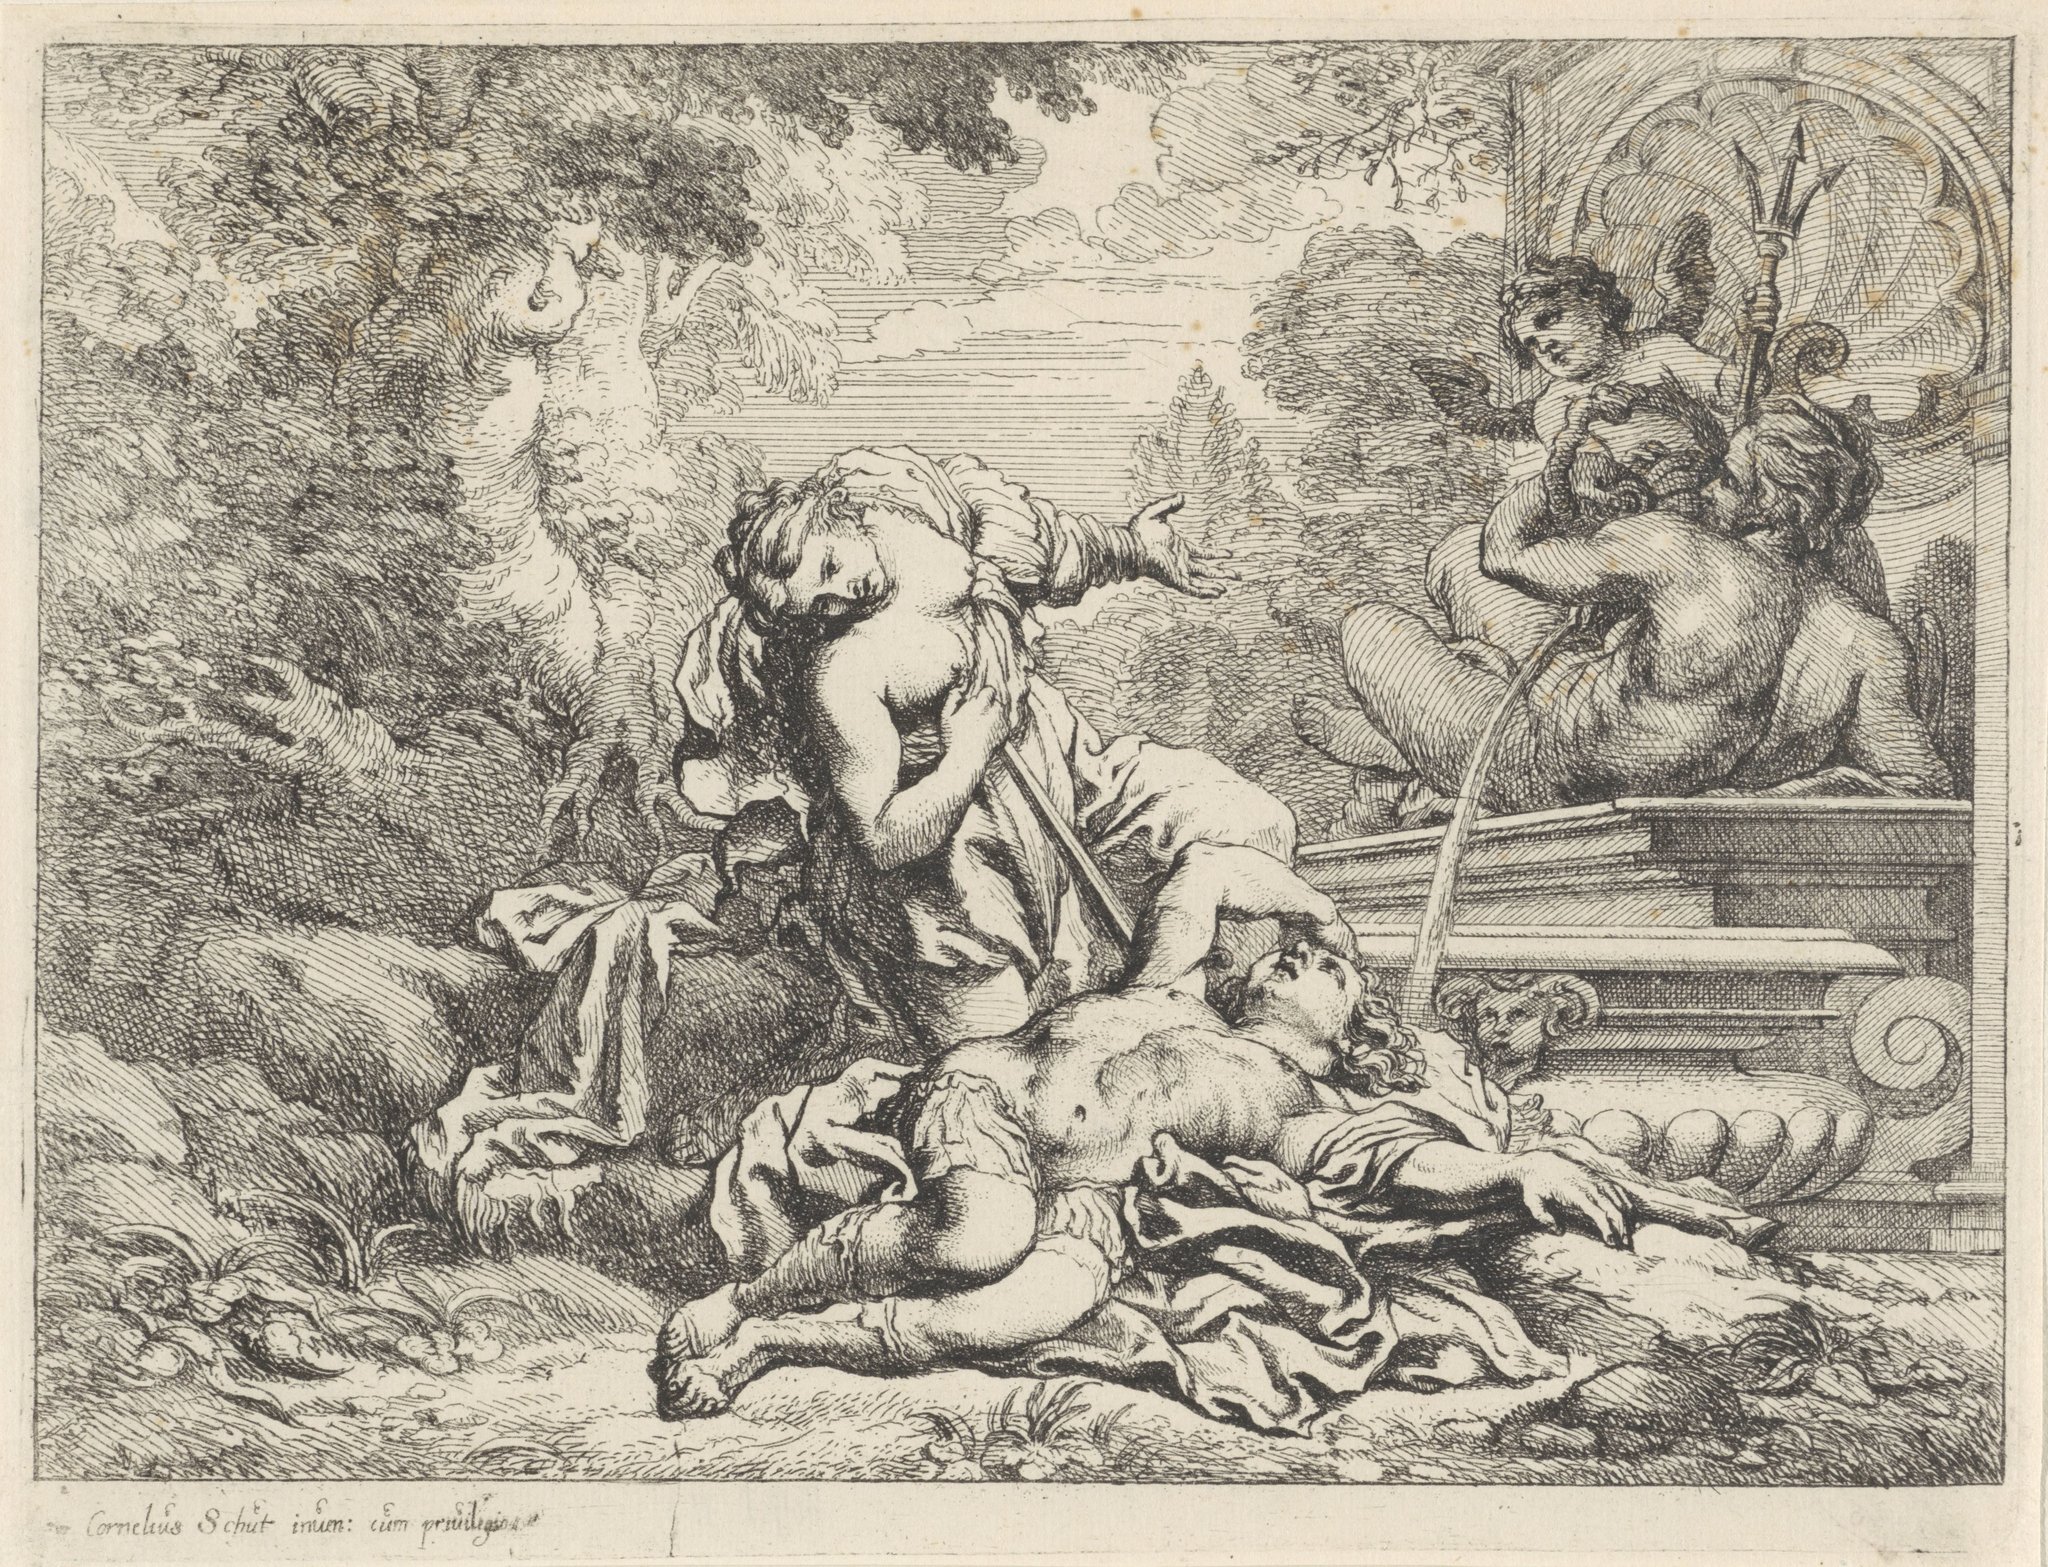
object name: print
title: Thisbe berooft zichzelf van het leven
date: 1618-1655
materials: paper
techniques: etching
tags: thisbe kills herself with pyramus' sword (the scene may be represented near a fountain)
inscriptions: collector's mark: Lugt 240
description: Thisbe stort zich in Pyramus' zwaard, nadat zij haar geliefde stervend aantrof bij de fontein. De besmeurde sluier die leidde tot het misverstand ligt achter haar.